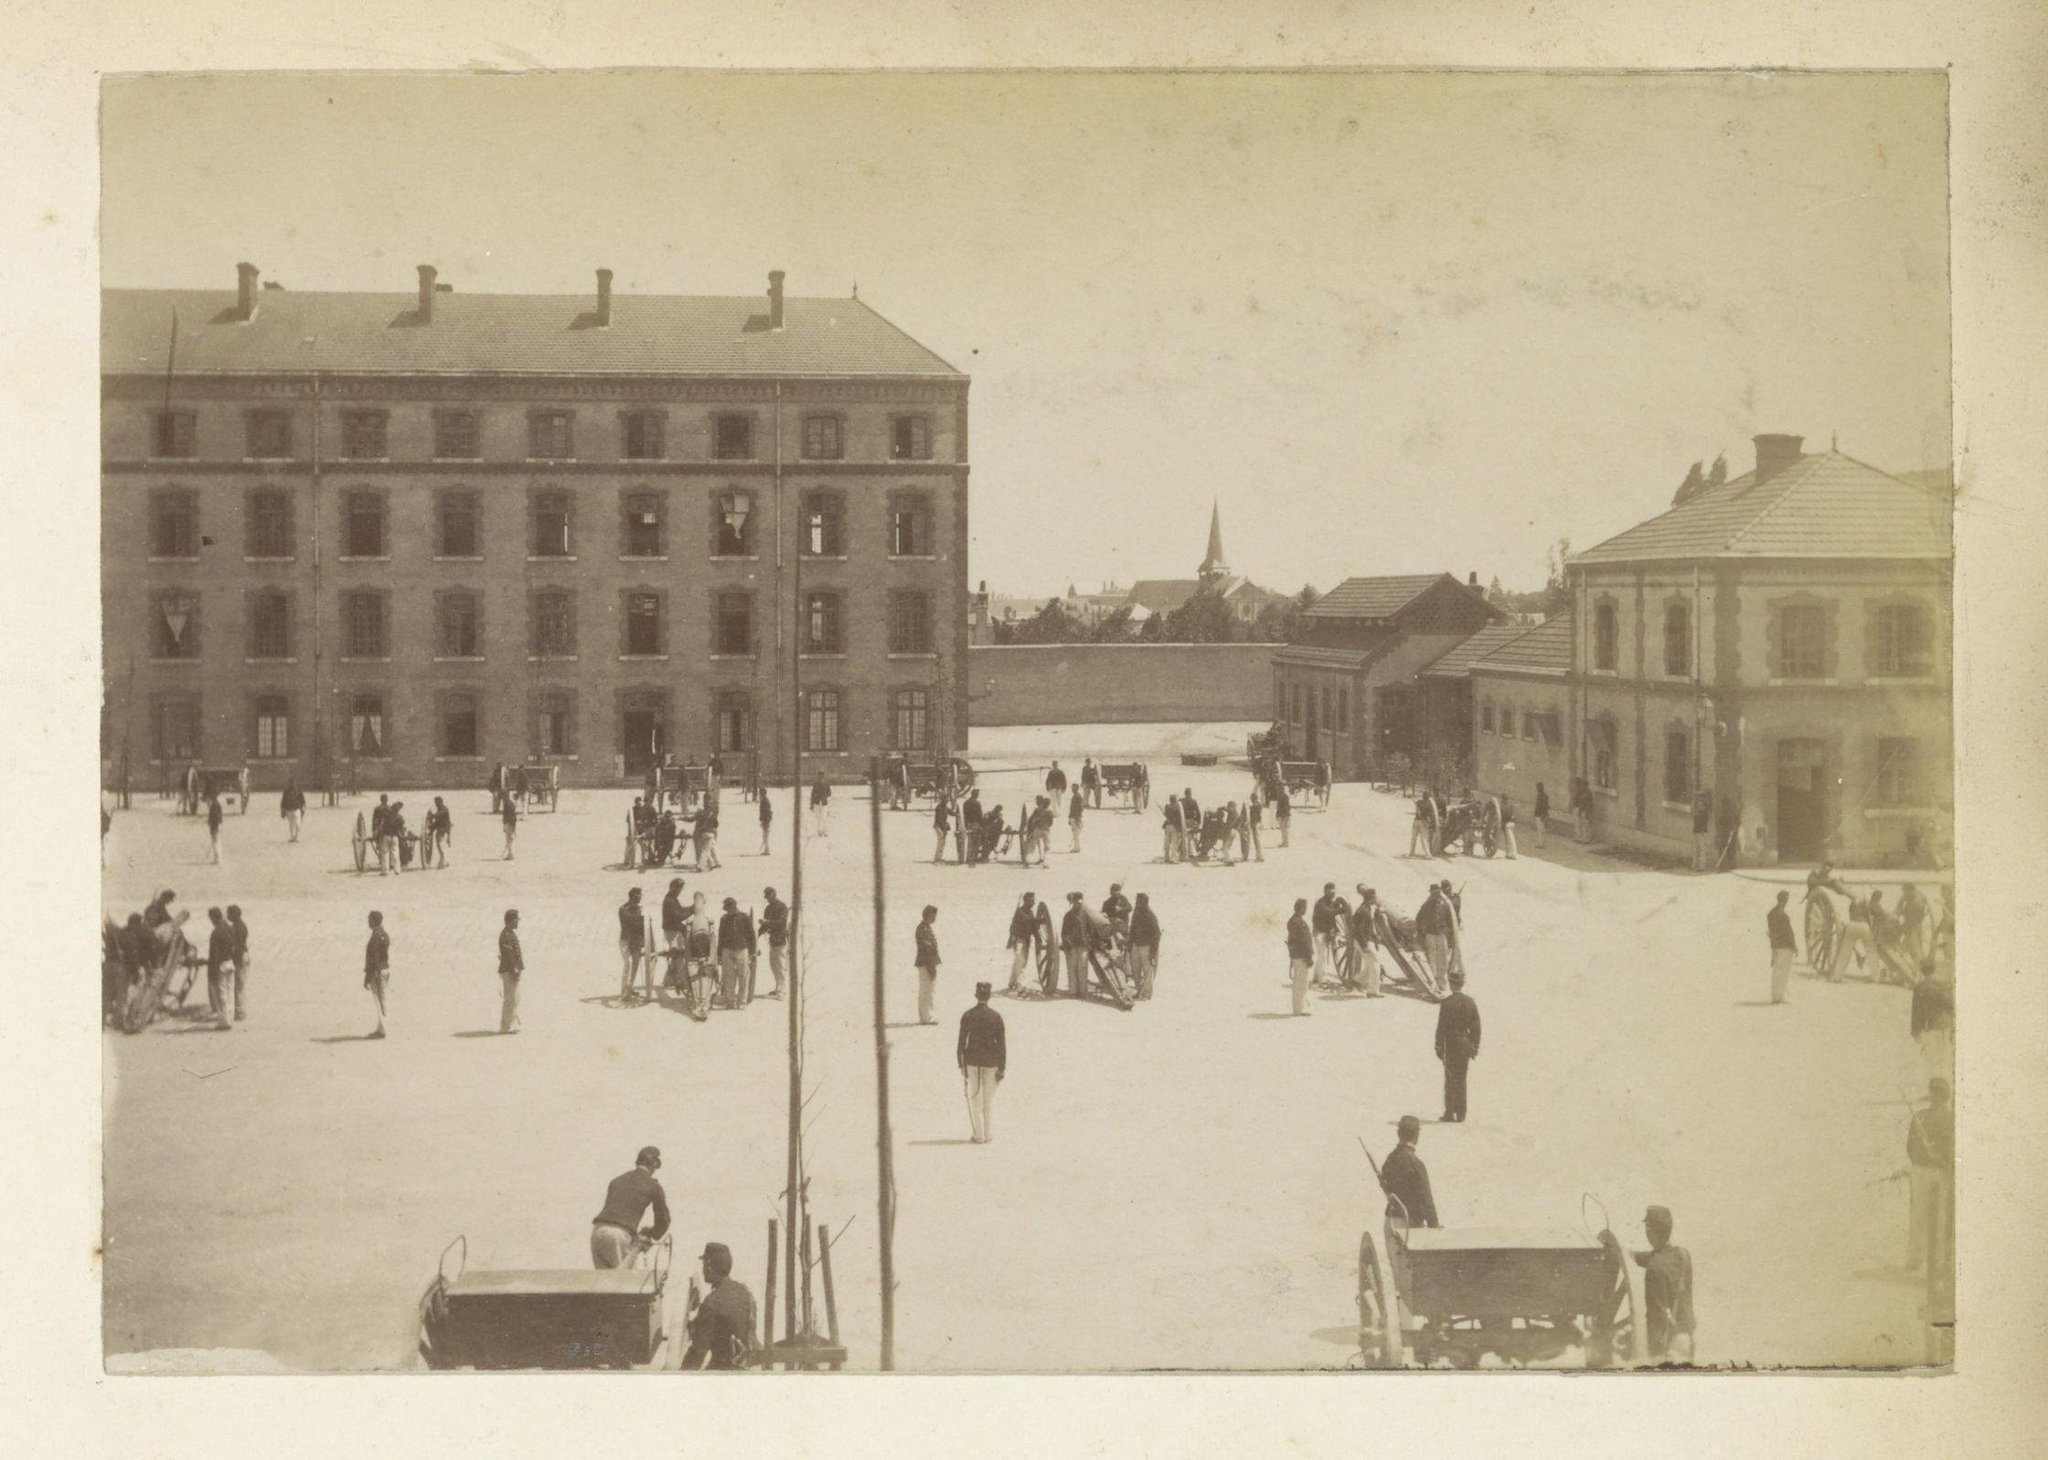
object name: photograph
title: Exercitieterrein van een kazerne met soldaten en kanonnen in Frankrijk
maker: Anonymous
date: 1900-1910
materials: paper, photographic support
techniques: albumen print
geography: france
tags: firearms: cannon (+ land forces), barracks (+ land forces), land forces, courtyard, france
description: Onderdeel van Fotoalbum van een Franse amateurfotograaf met opnames van een familie, distilleerderij Delizy & Doistau Fils, het leger en bezienswaardigheden in Frankrijk.